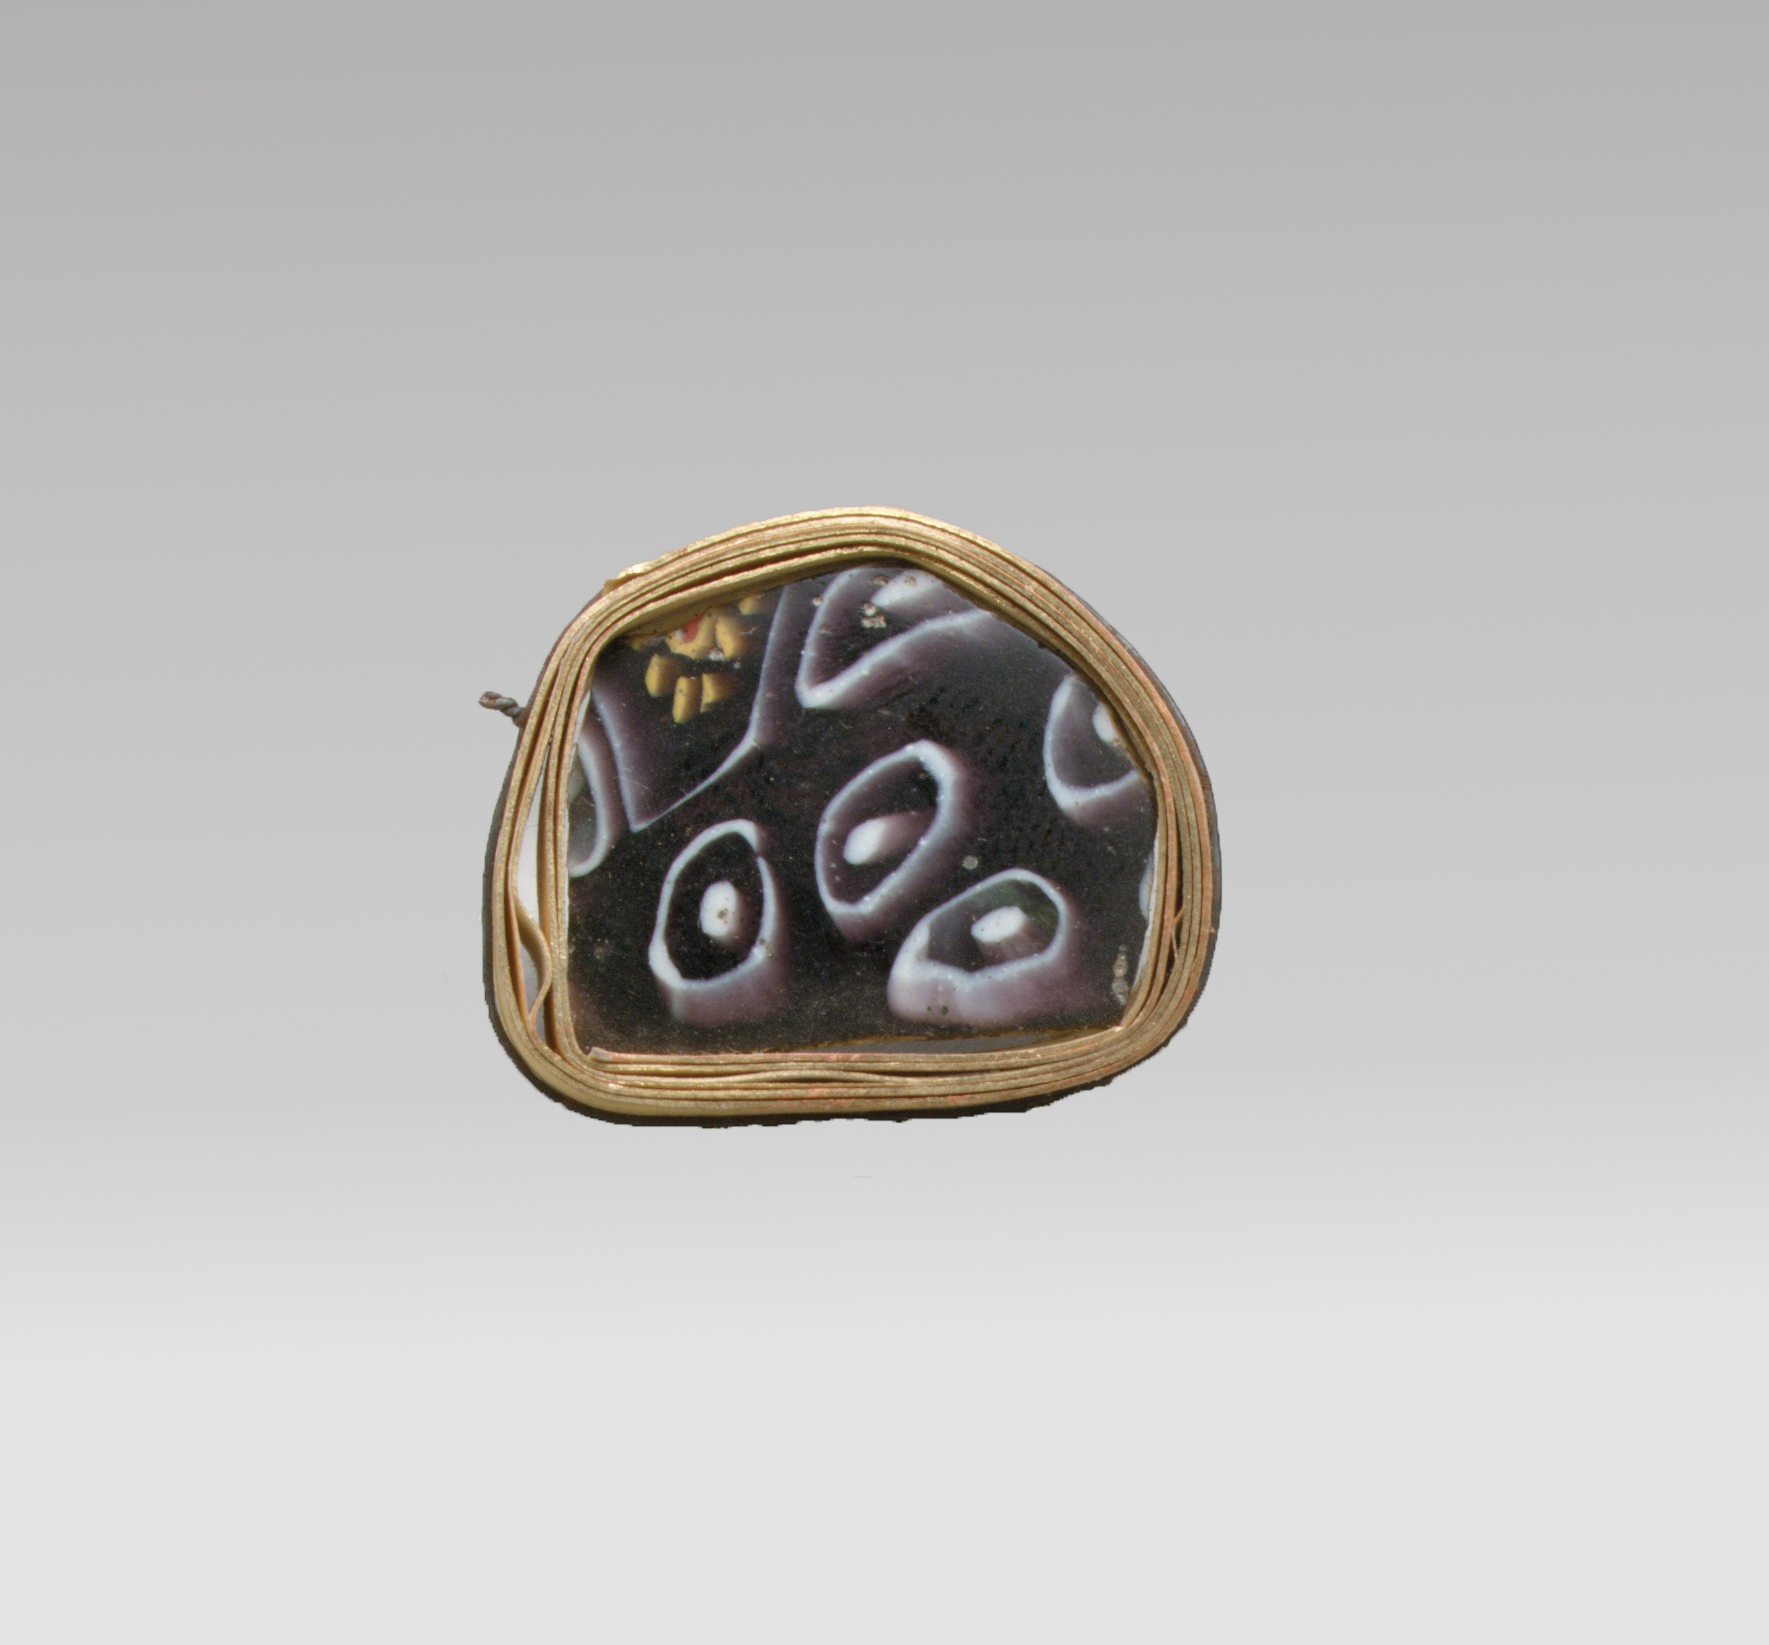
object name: fragment, mosaic bowl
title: Glass mosaic bowl fragment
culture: roman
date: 34 BCE-33 CE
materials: glass